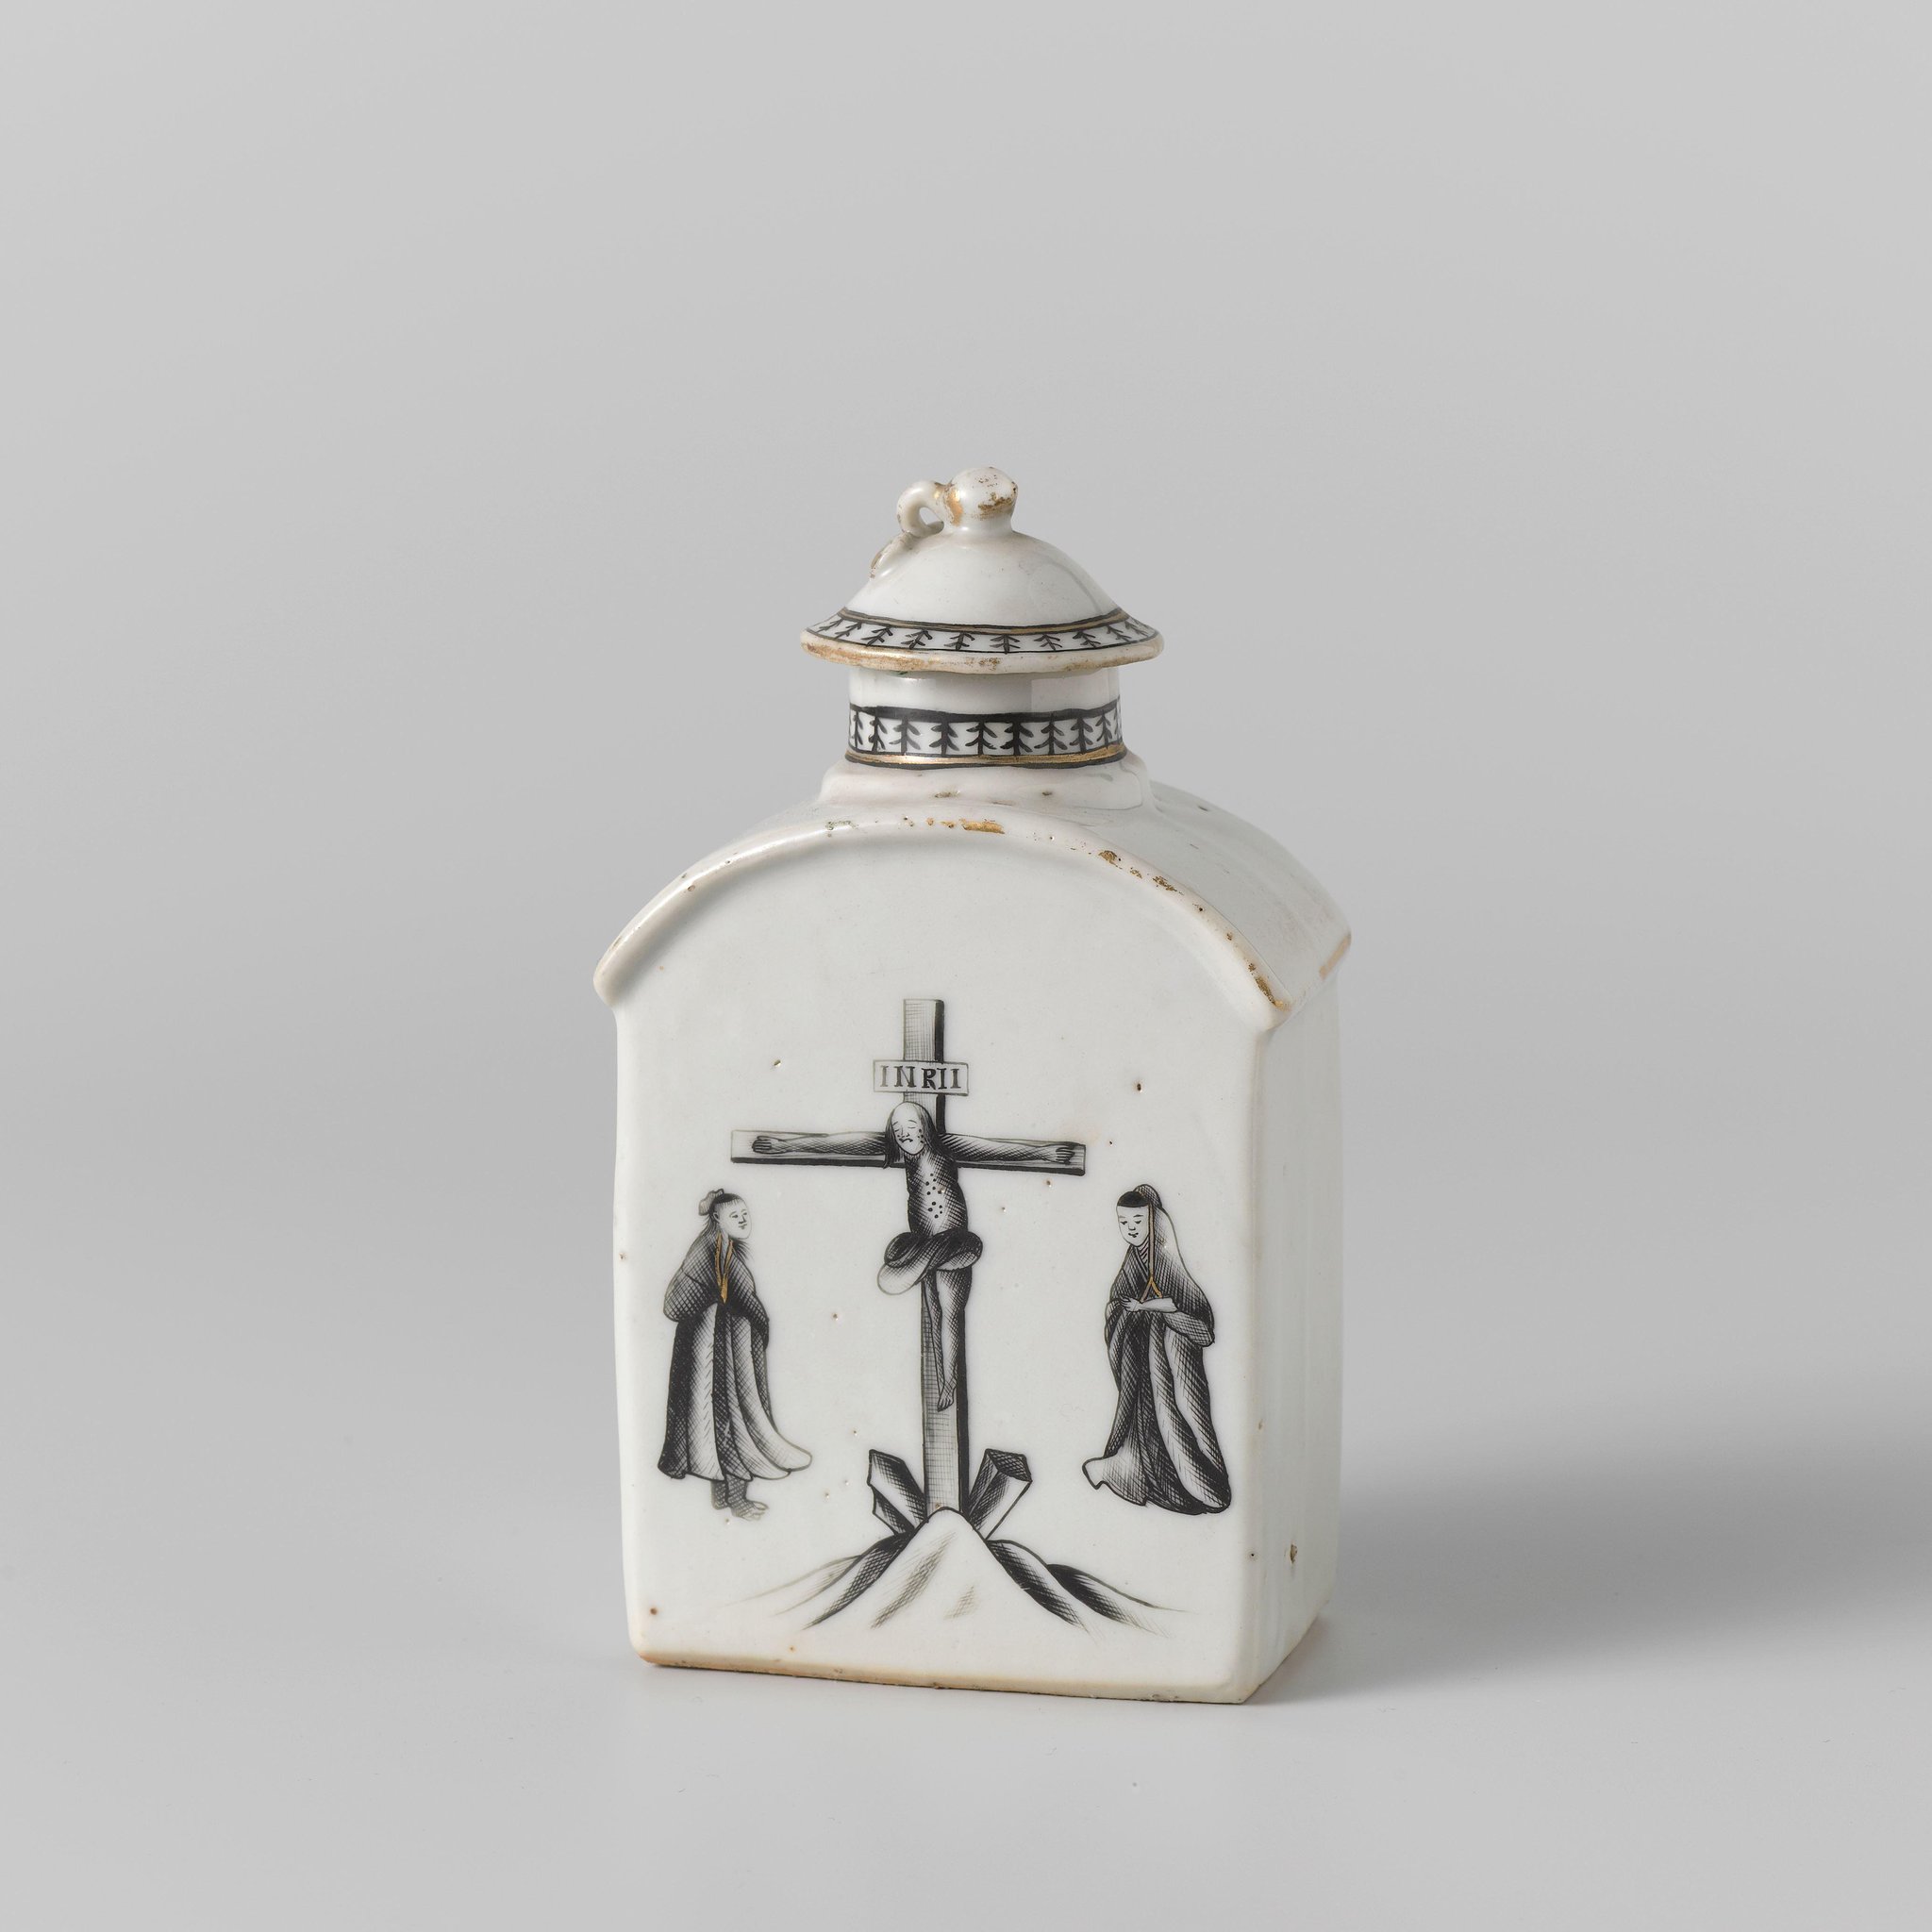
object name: tea caddy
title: Rectangular tea caddy with a crucifixion scene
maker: Anonymous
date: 1780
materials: glaze, gold, paint, porcelain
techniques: firing, forming, gilding, turning, vitrification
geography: china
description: Rechthoekige theebus van porselein met iets verdikte, ronde schouder, beschilderd op het glazuur in zwart en goud. Op de buitenzijde tweemaal een voorstelling van de Kruisiging met de twee Maria's; de nek met een band met een decoratief patroon. Onderzijde ongeglazuurd. Onderdeel van een theeservies. Europese voorstelling in encre de Chine.